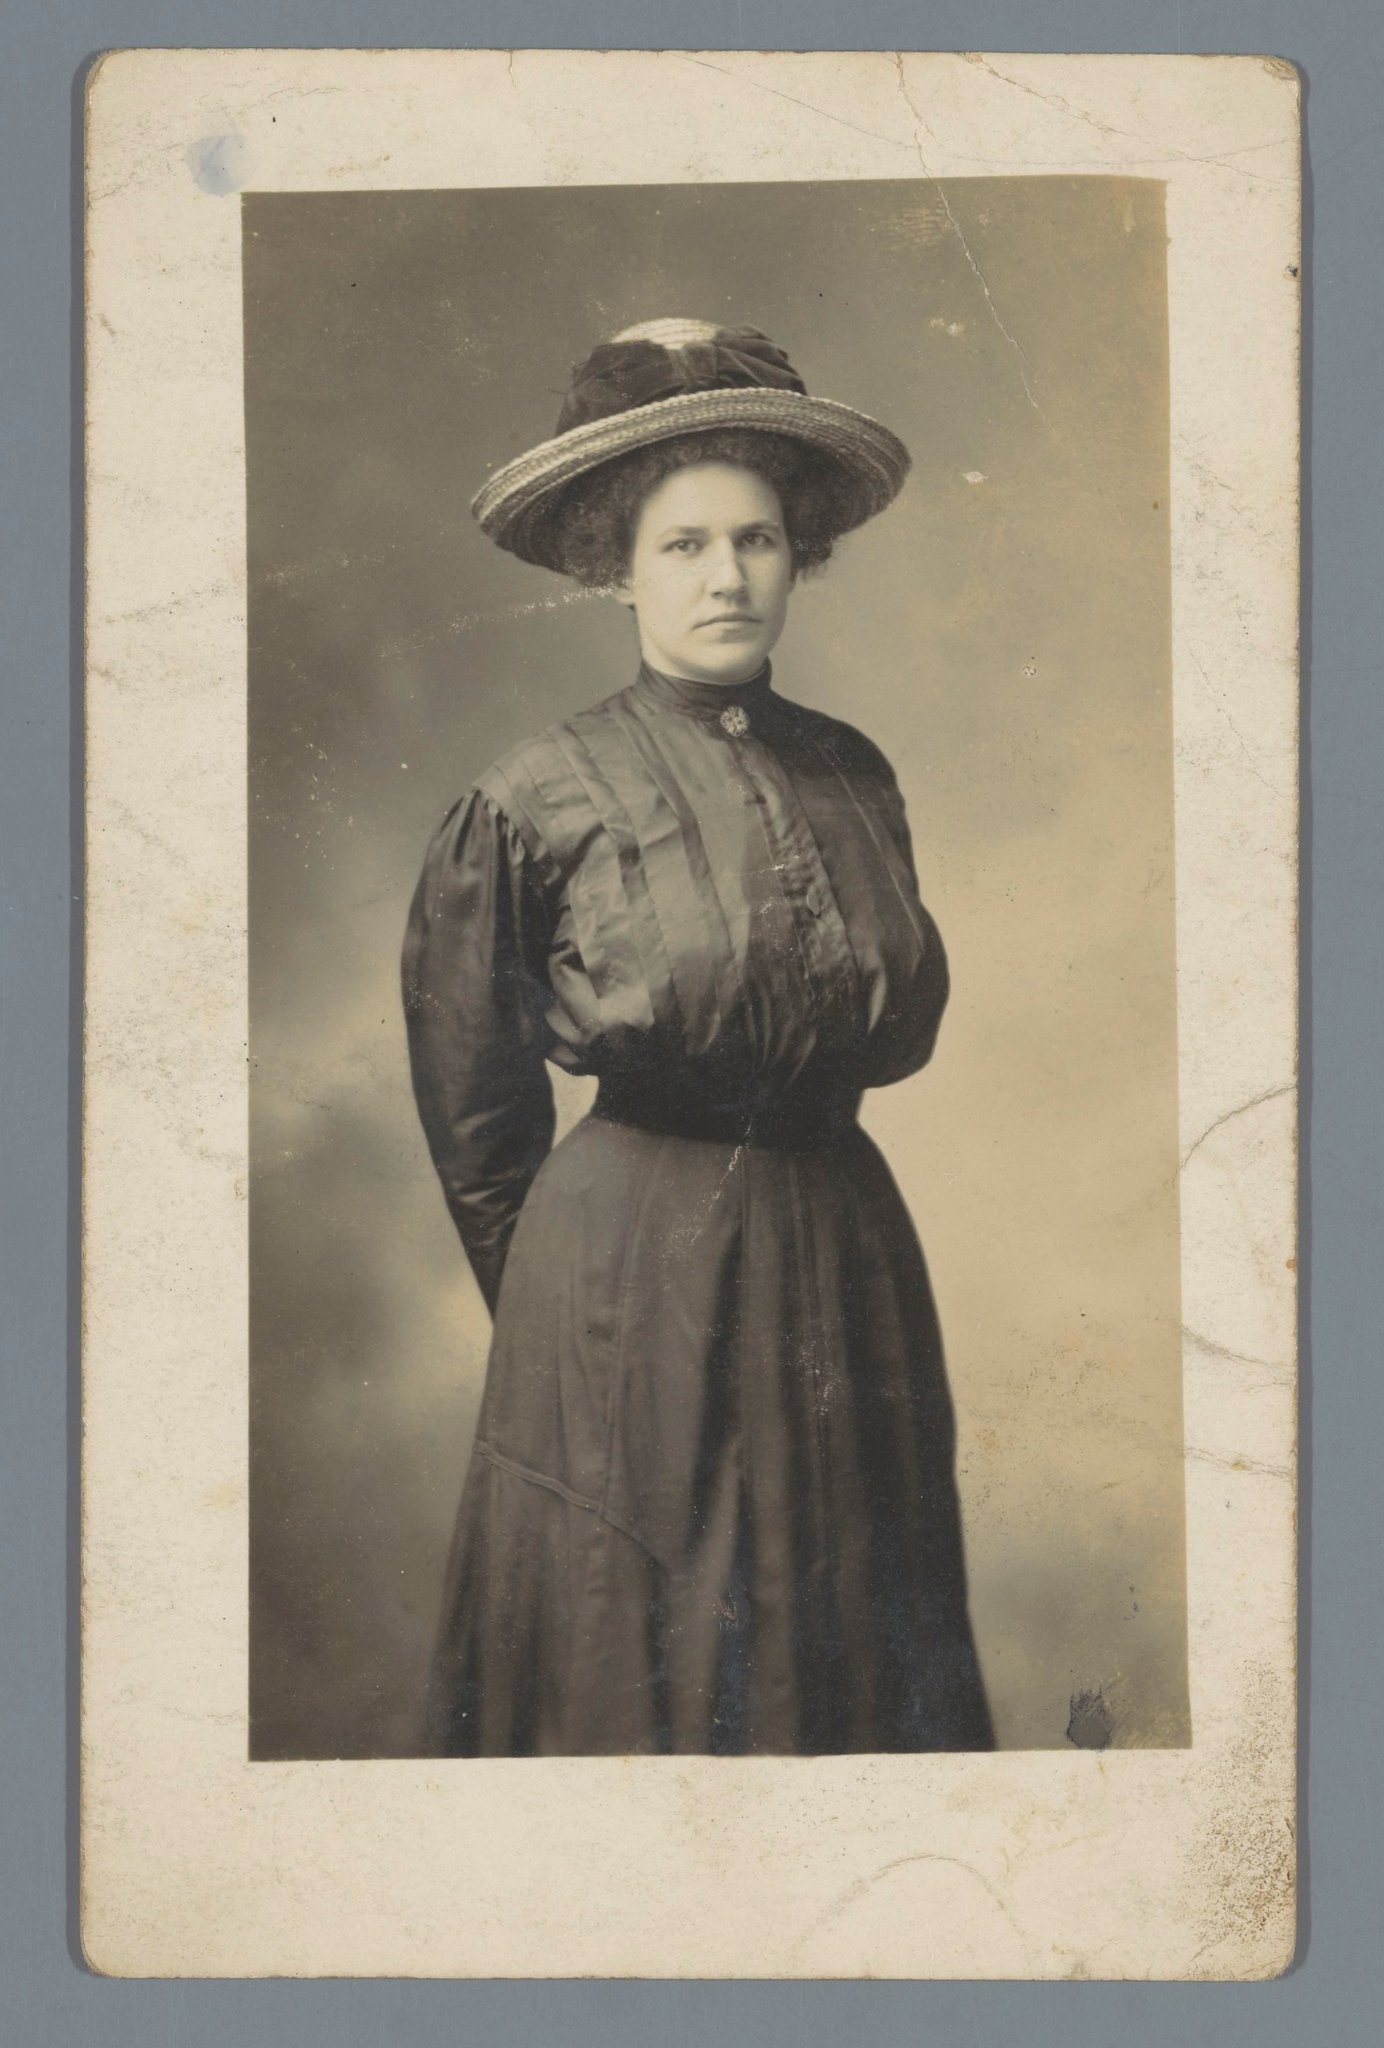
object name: ansichtkaart, prentbriefkaart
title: Portret van een onbekende vrouw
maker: Anonymous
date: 1907-1920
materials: photographic support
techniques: gelatin silver print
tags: adult woman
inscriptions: inscription: ‘Lieve Zuster (...) Be good again that is wat I wish’